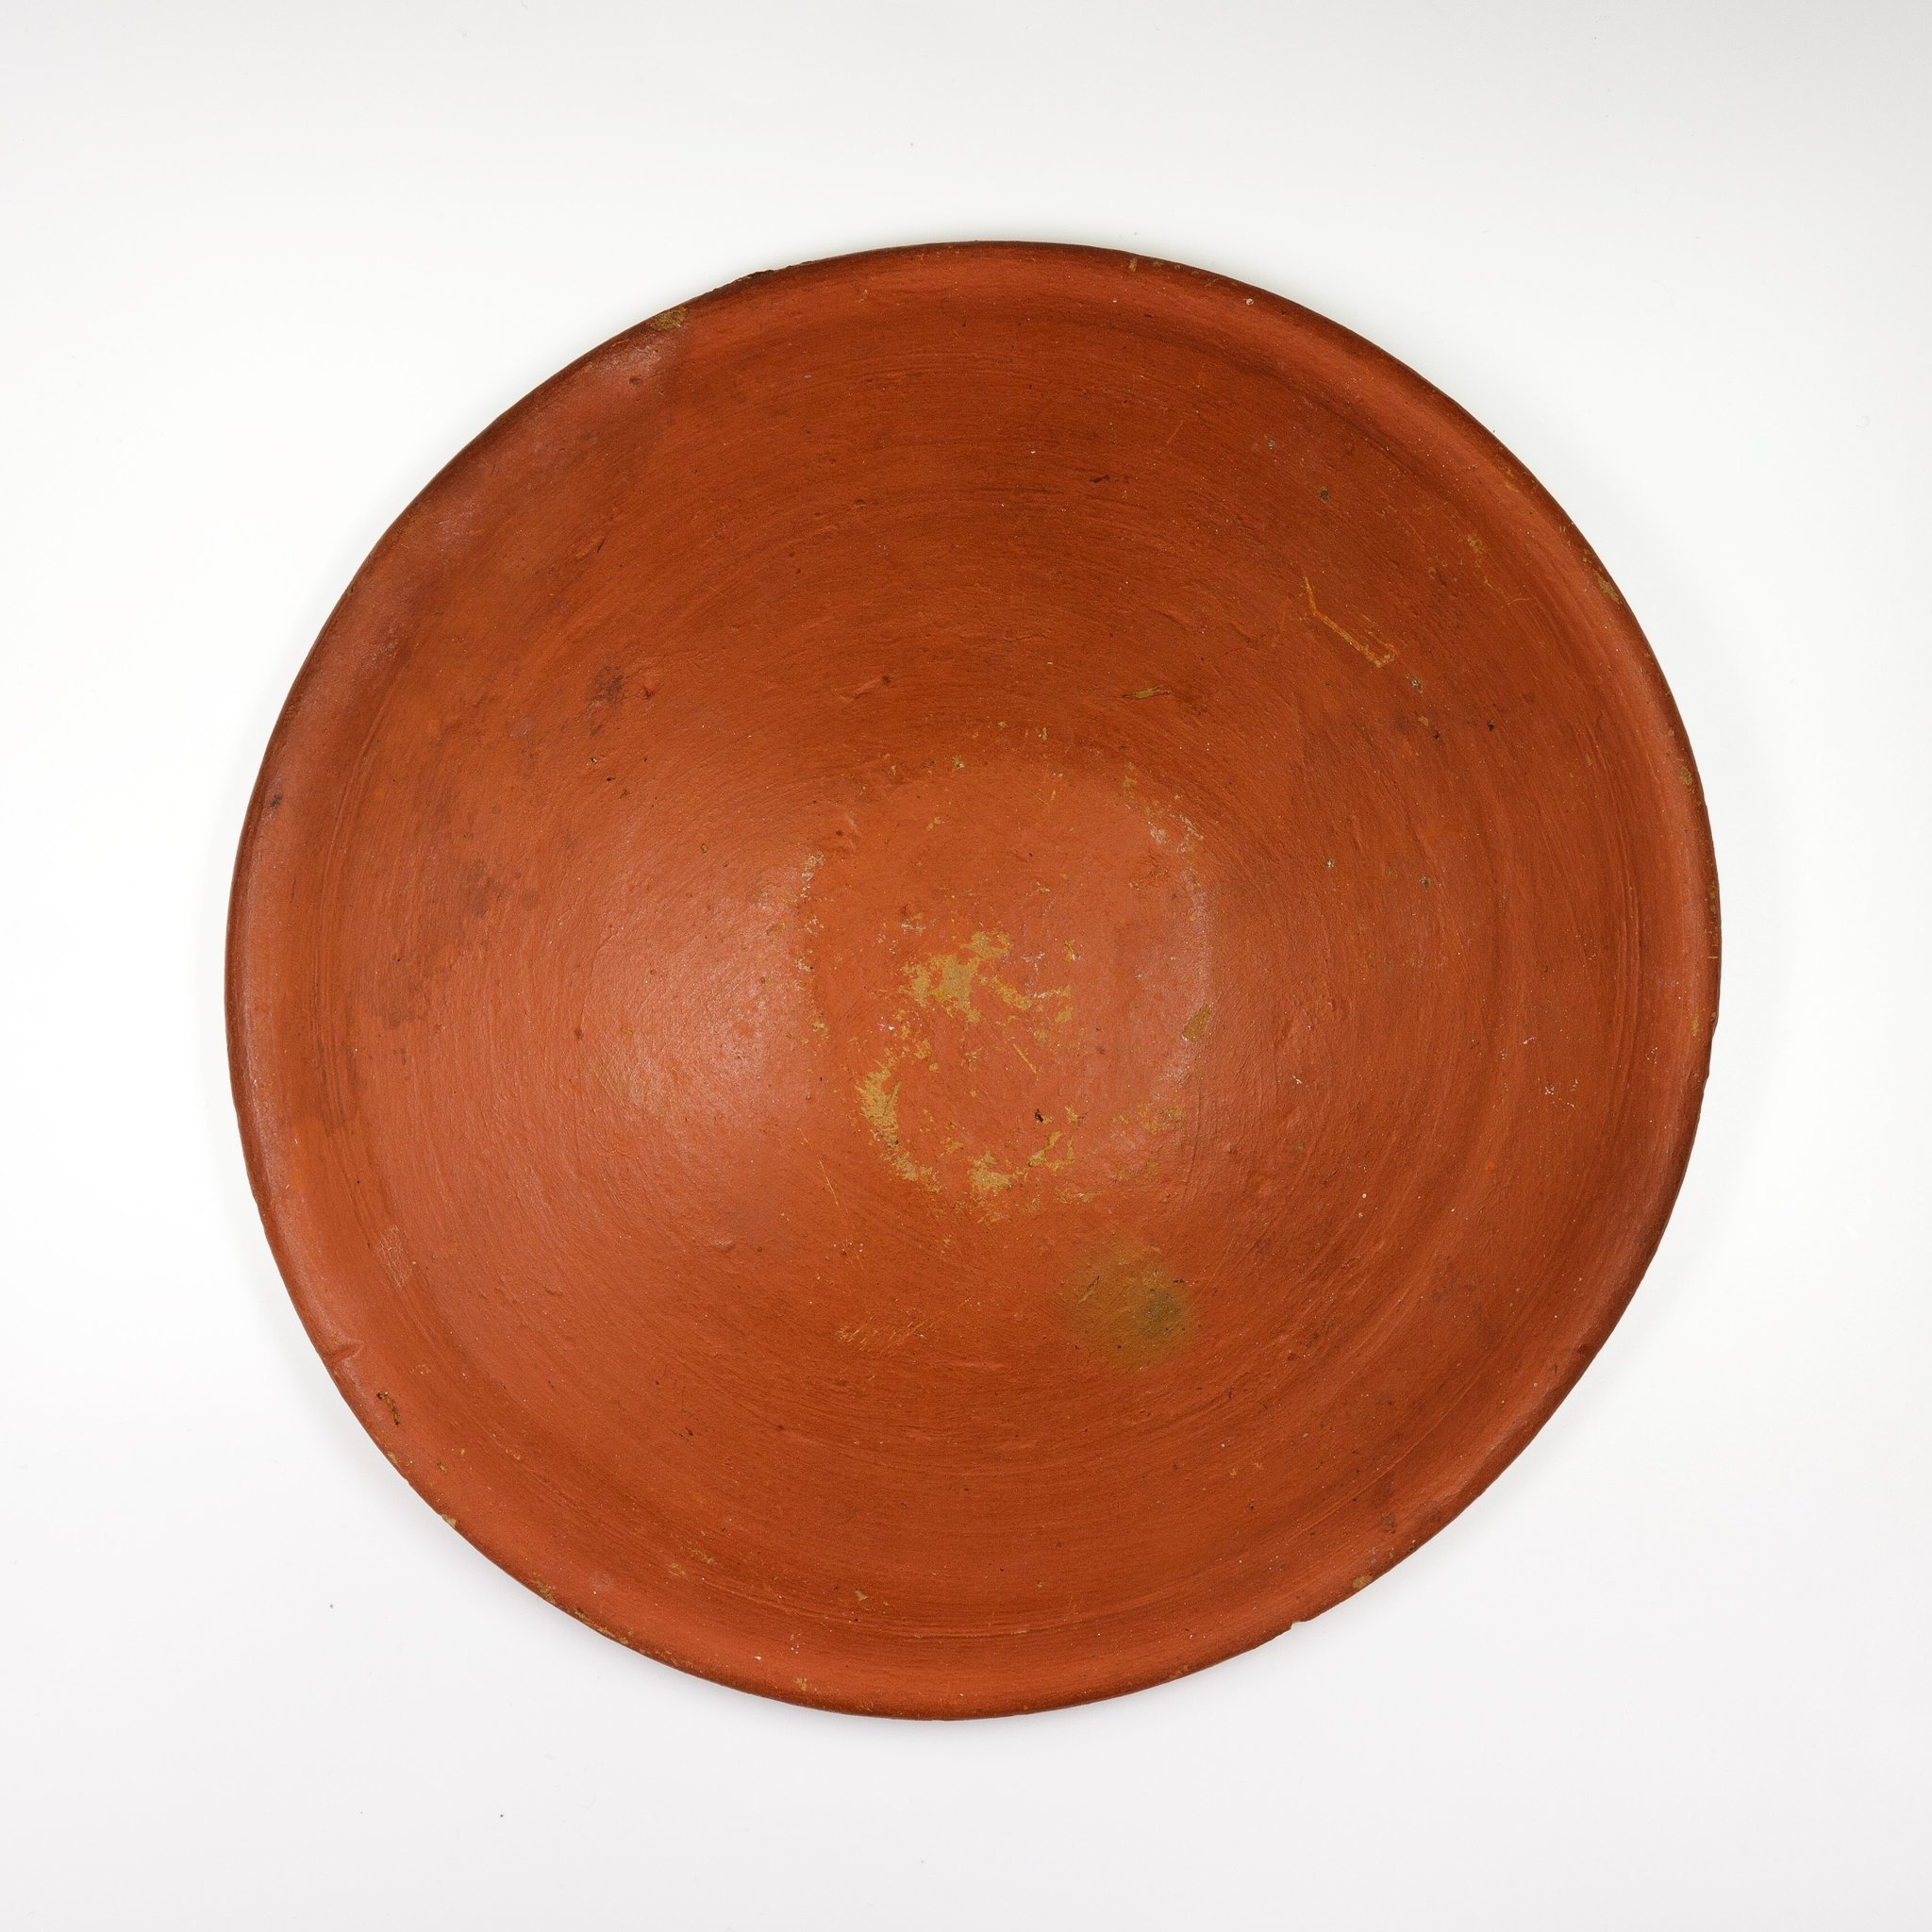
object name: dish, flat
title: Dish from Tutankhamun's Embalming Cache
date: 1336-1327 BCE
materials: mineral, pottery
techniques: wash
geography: egypt